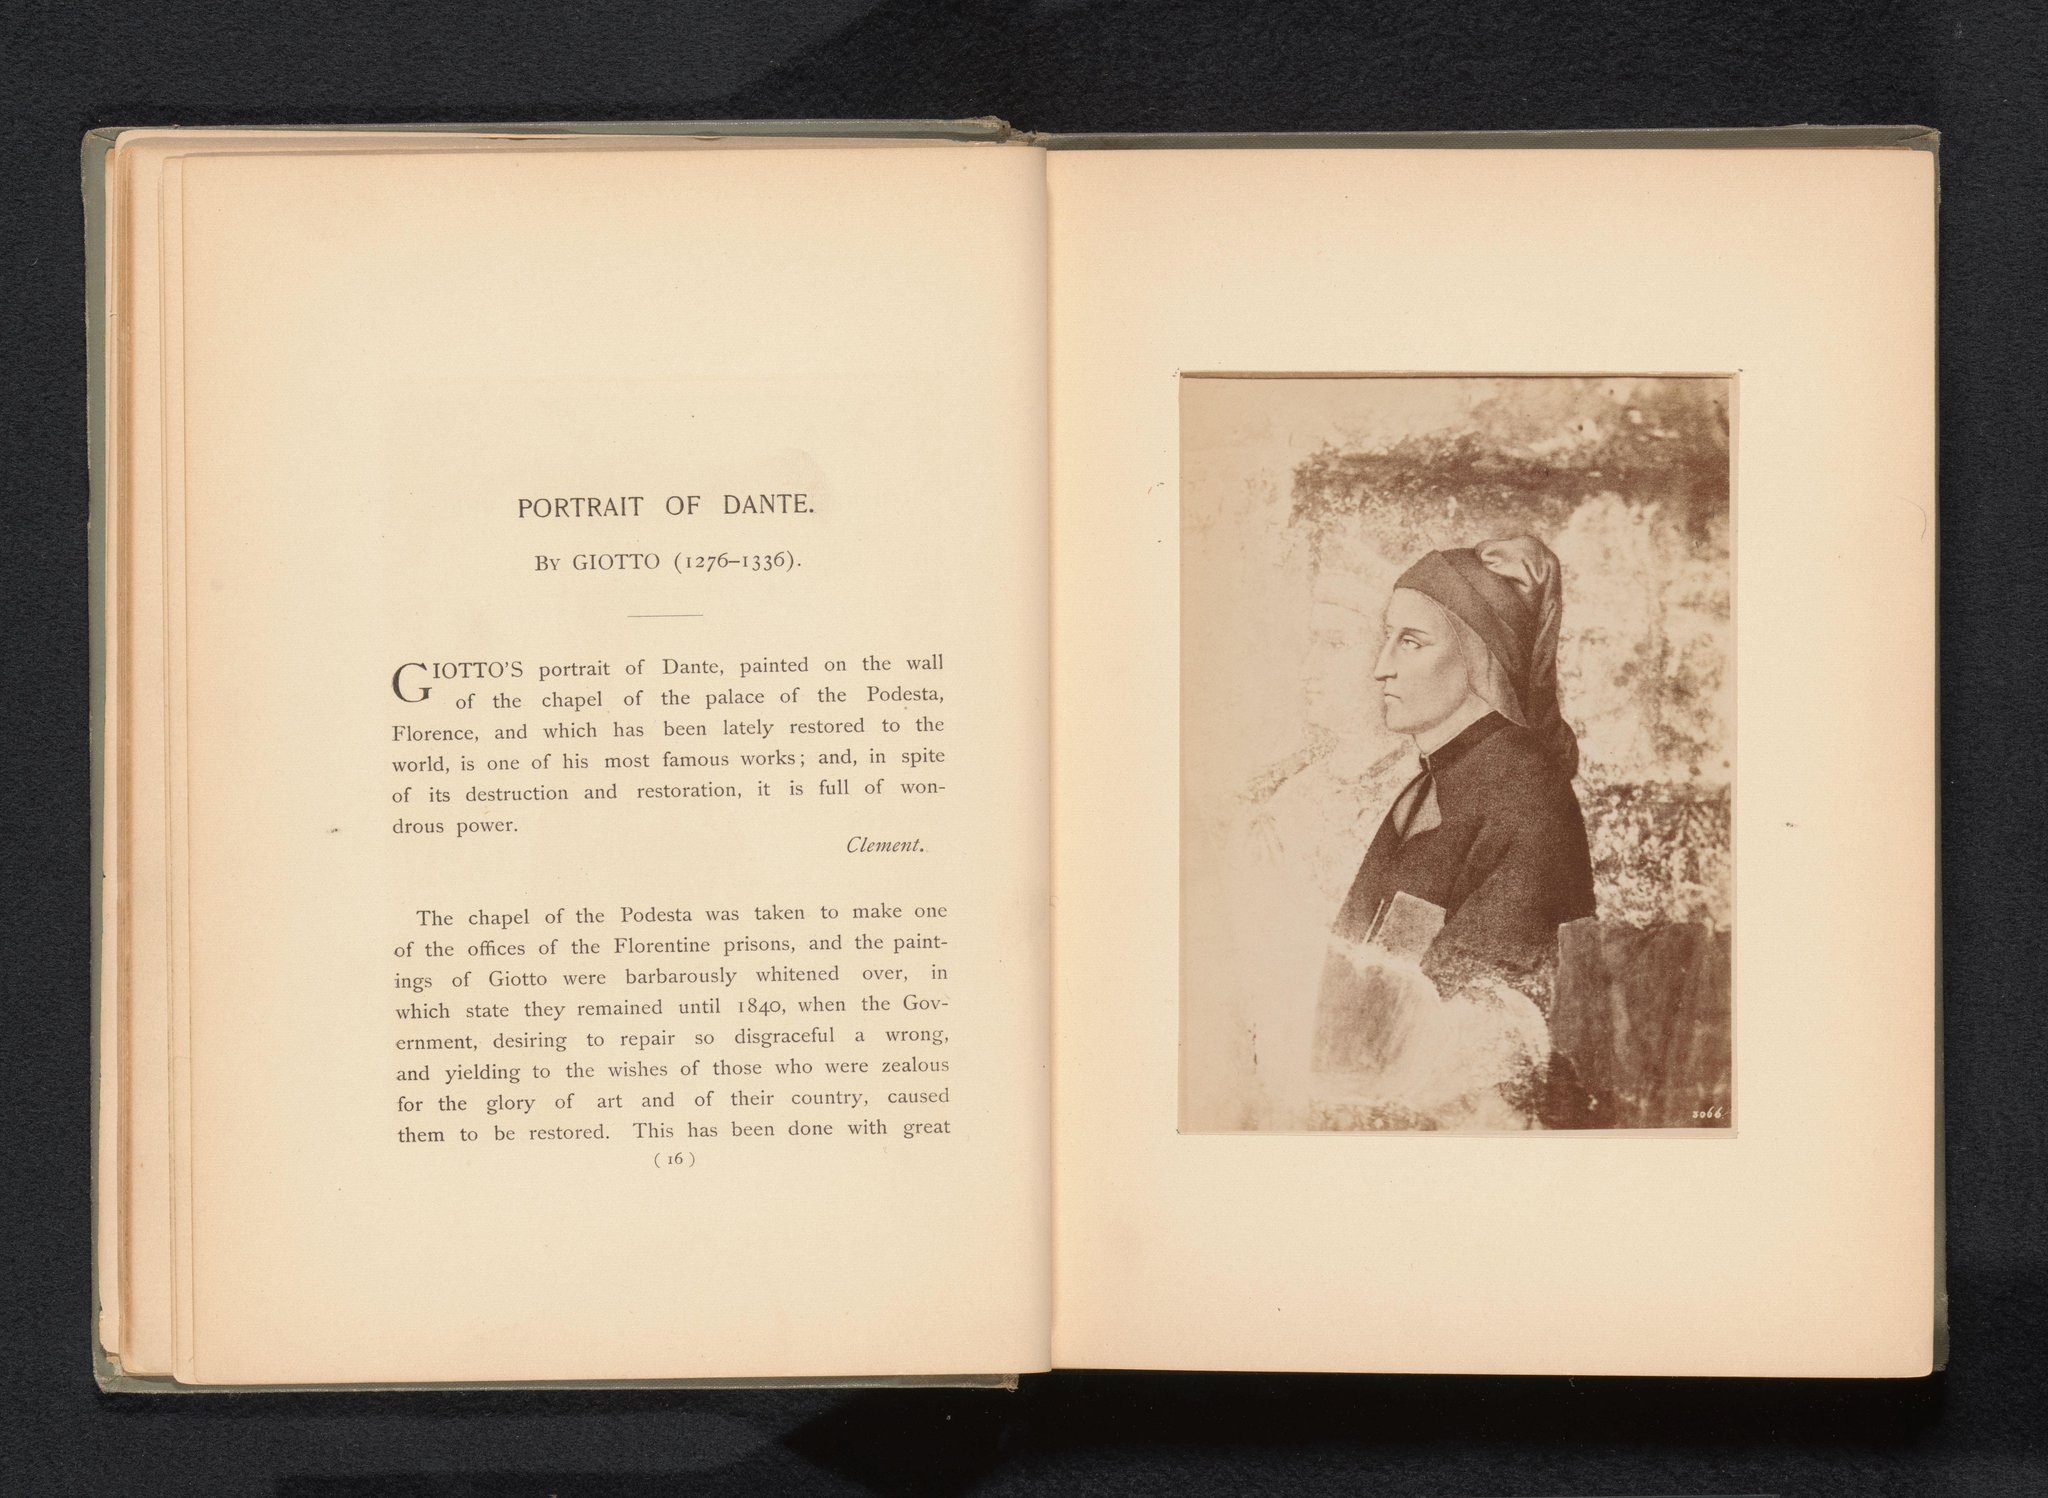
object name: reproduction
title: Fotoreproductie van een schilderij, voorstellende een portret van Dante Alighieri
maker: Anonymous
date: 1882-1887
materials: photographic support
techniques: albumen print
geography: palazzo del bargello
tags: dante alighieri, portrait of a writer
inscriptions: number: ‘3066’